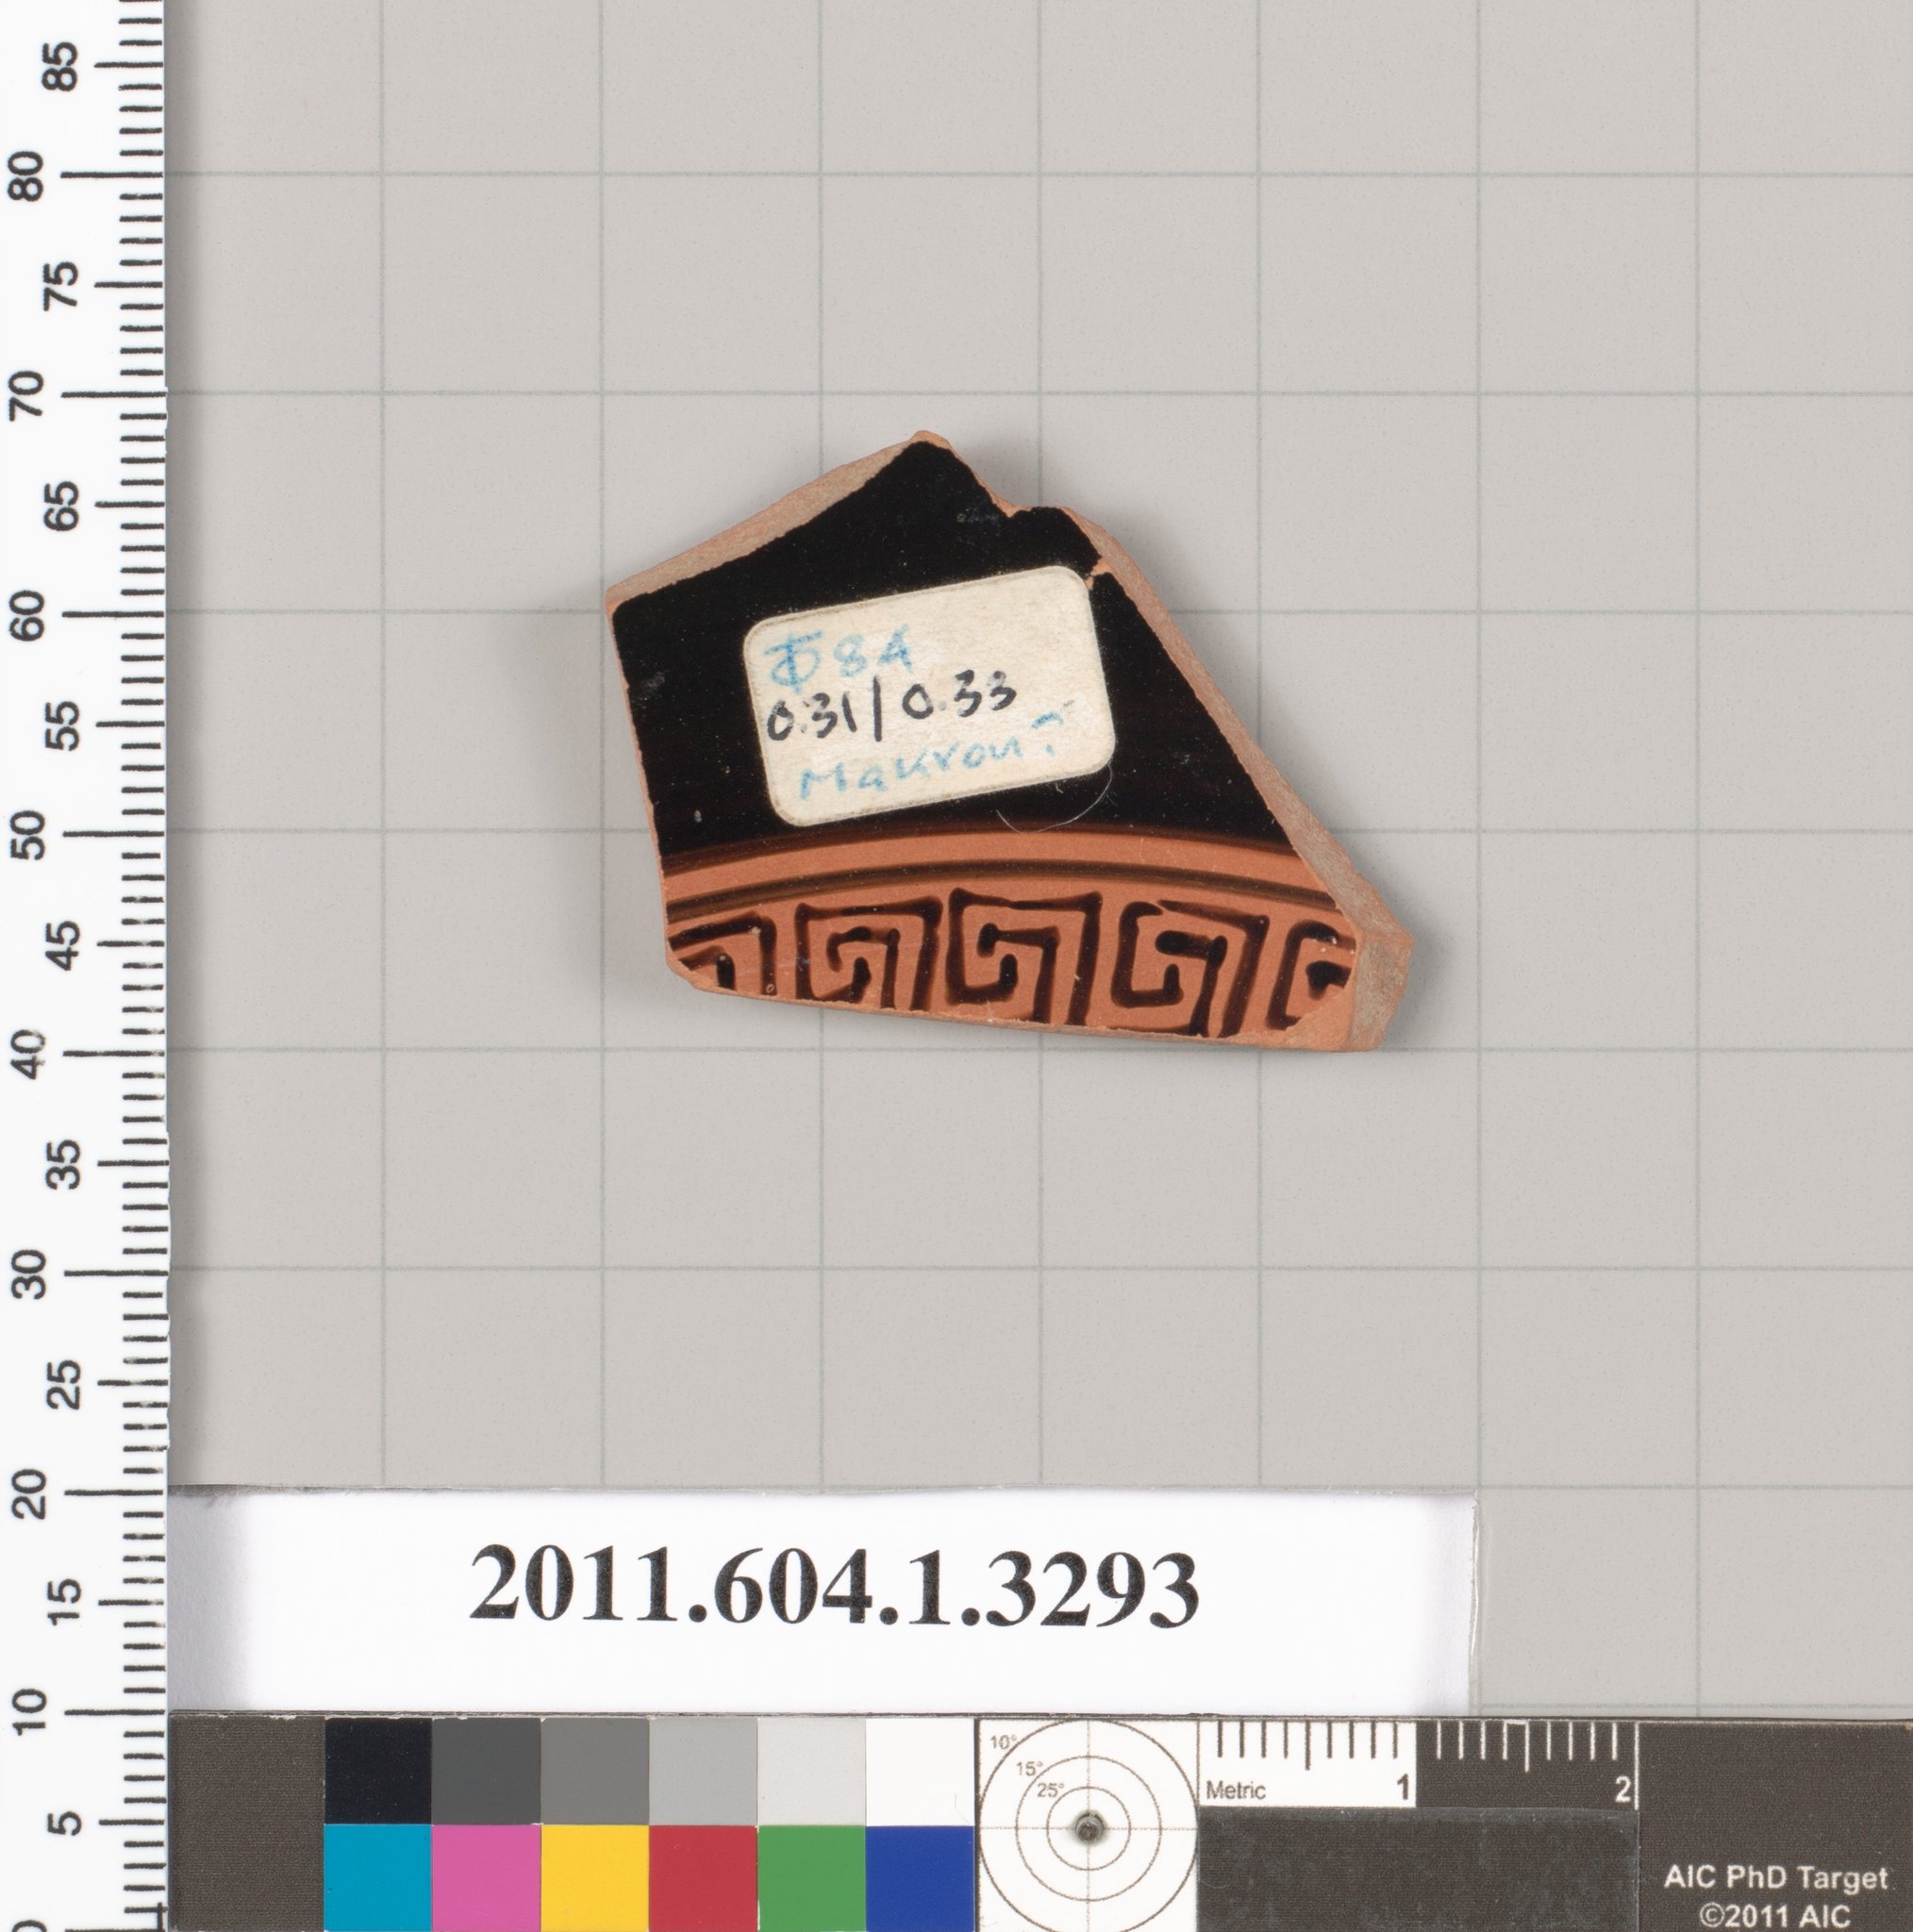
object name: kylix fragment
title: Terracotta fragment of a kylix (drinking cup)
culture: greek, attic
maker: makron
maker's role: artist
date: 490-480 BCE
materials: terracotta